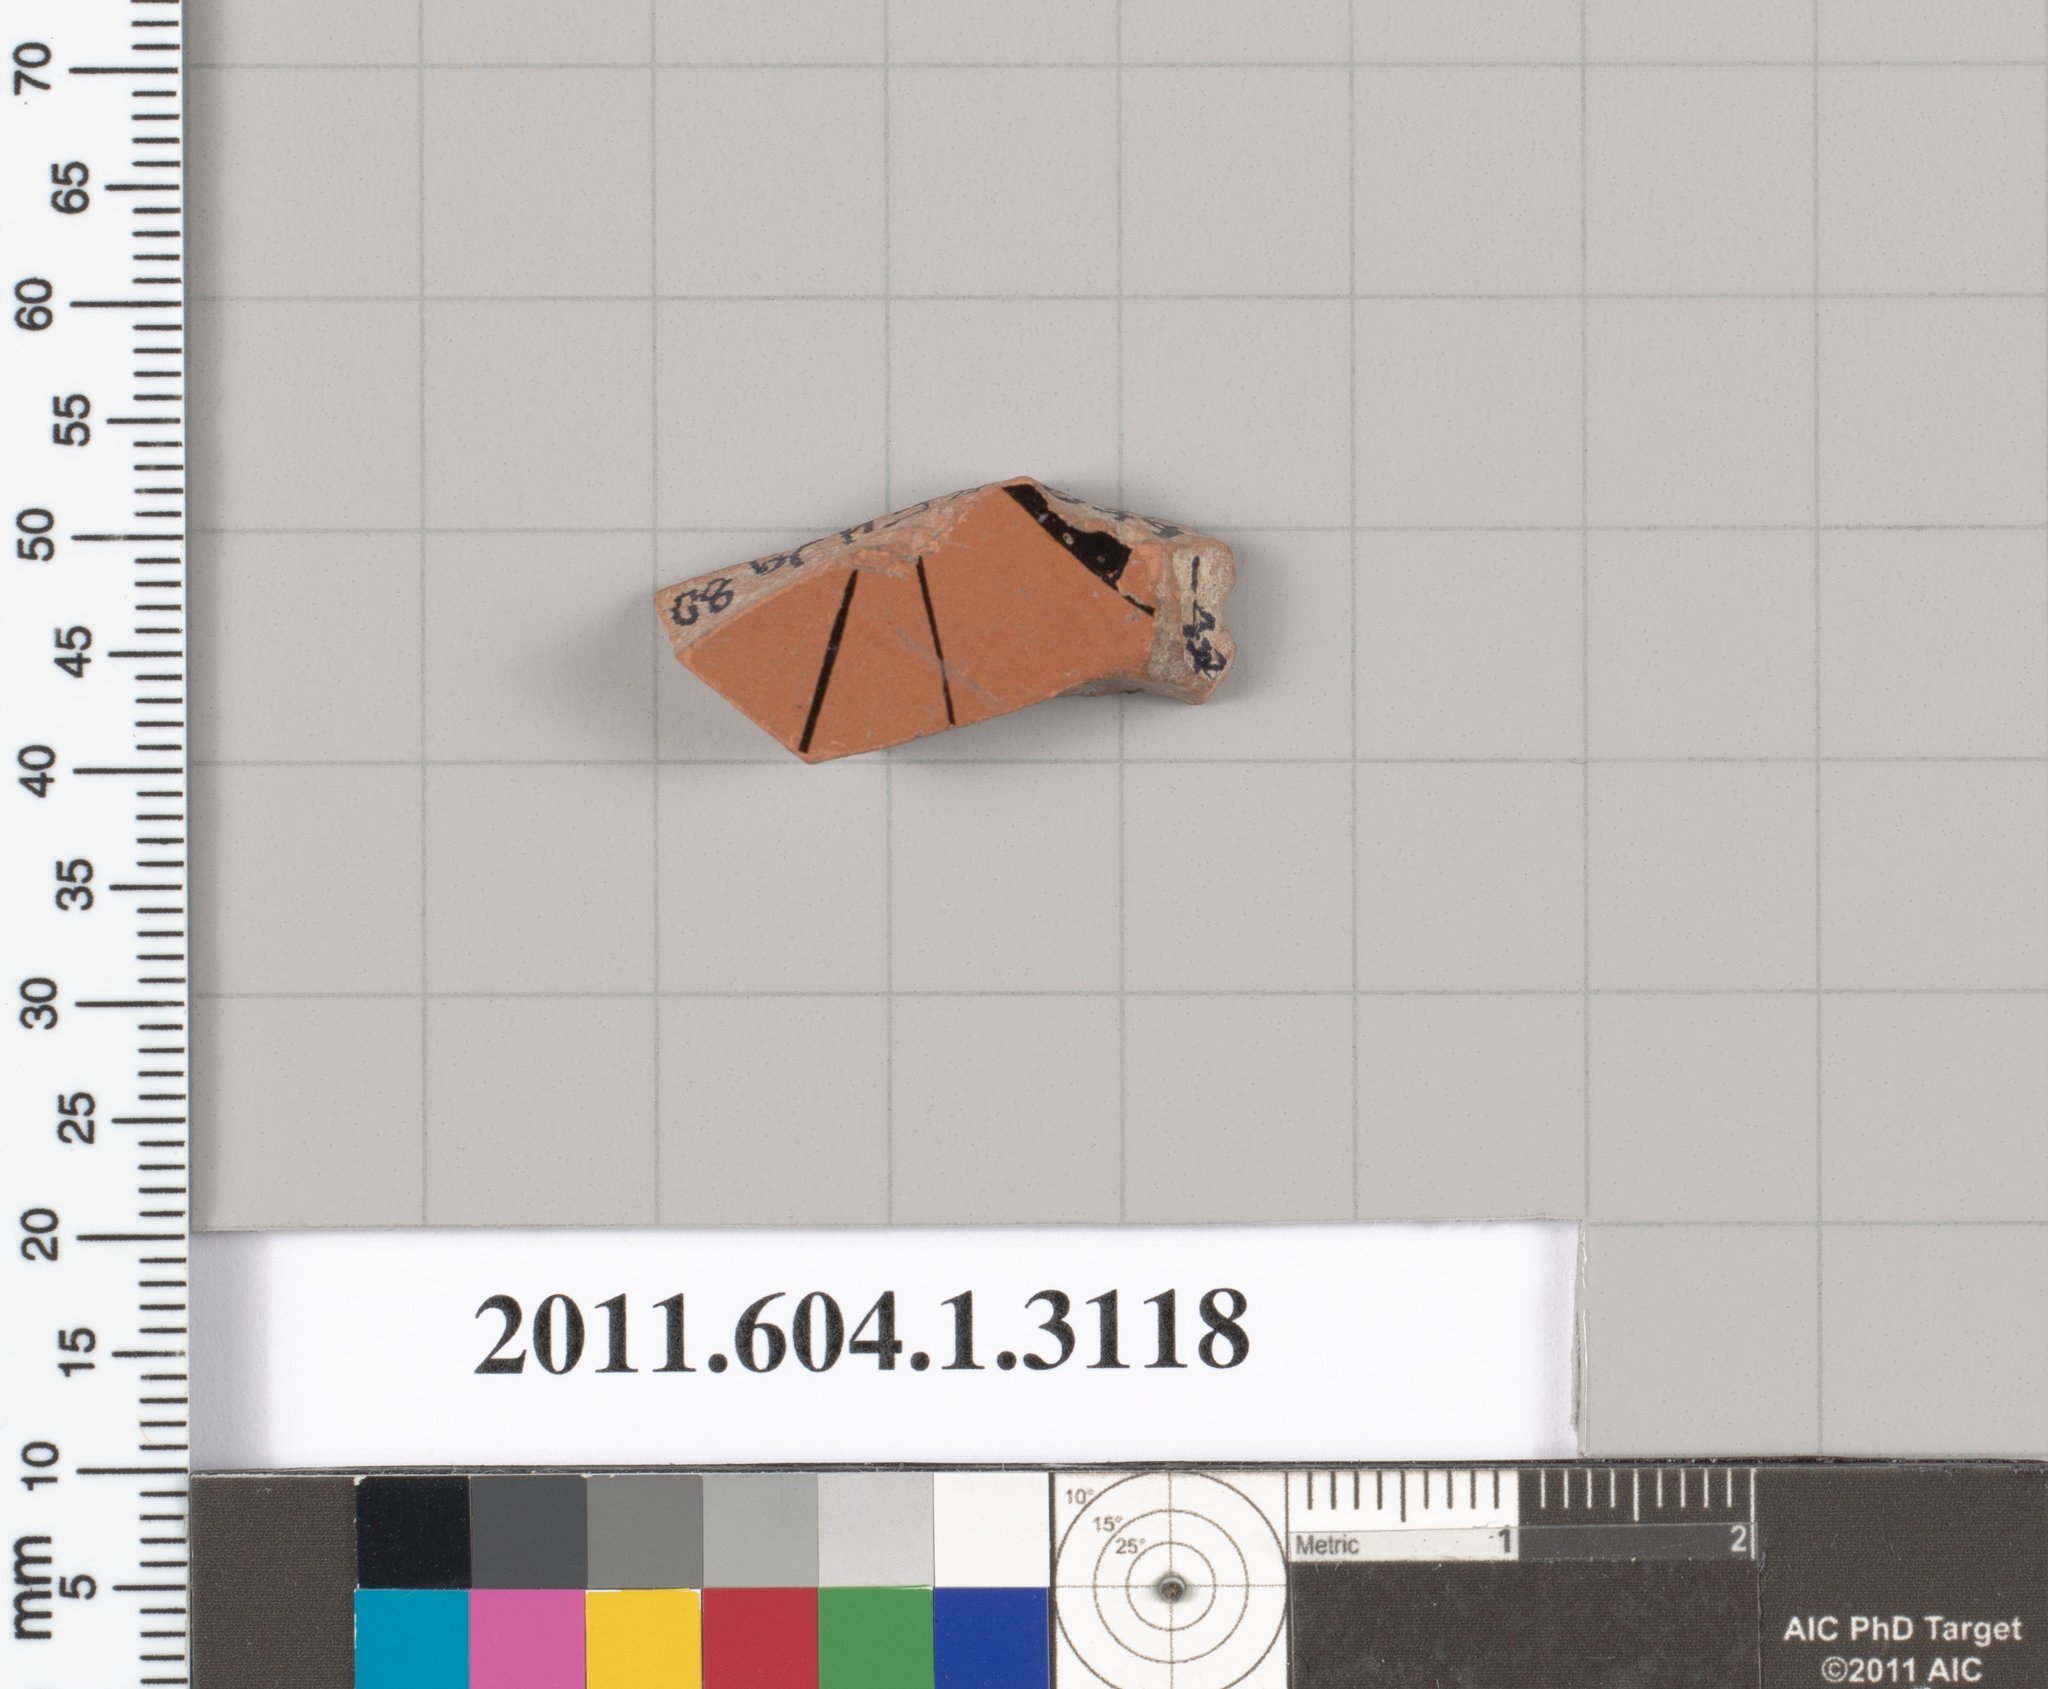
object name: kylix fragment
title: Terracotta fragment of a kylix (drinking cup)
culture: greek, attic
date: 475-451 BCE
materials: terracotta